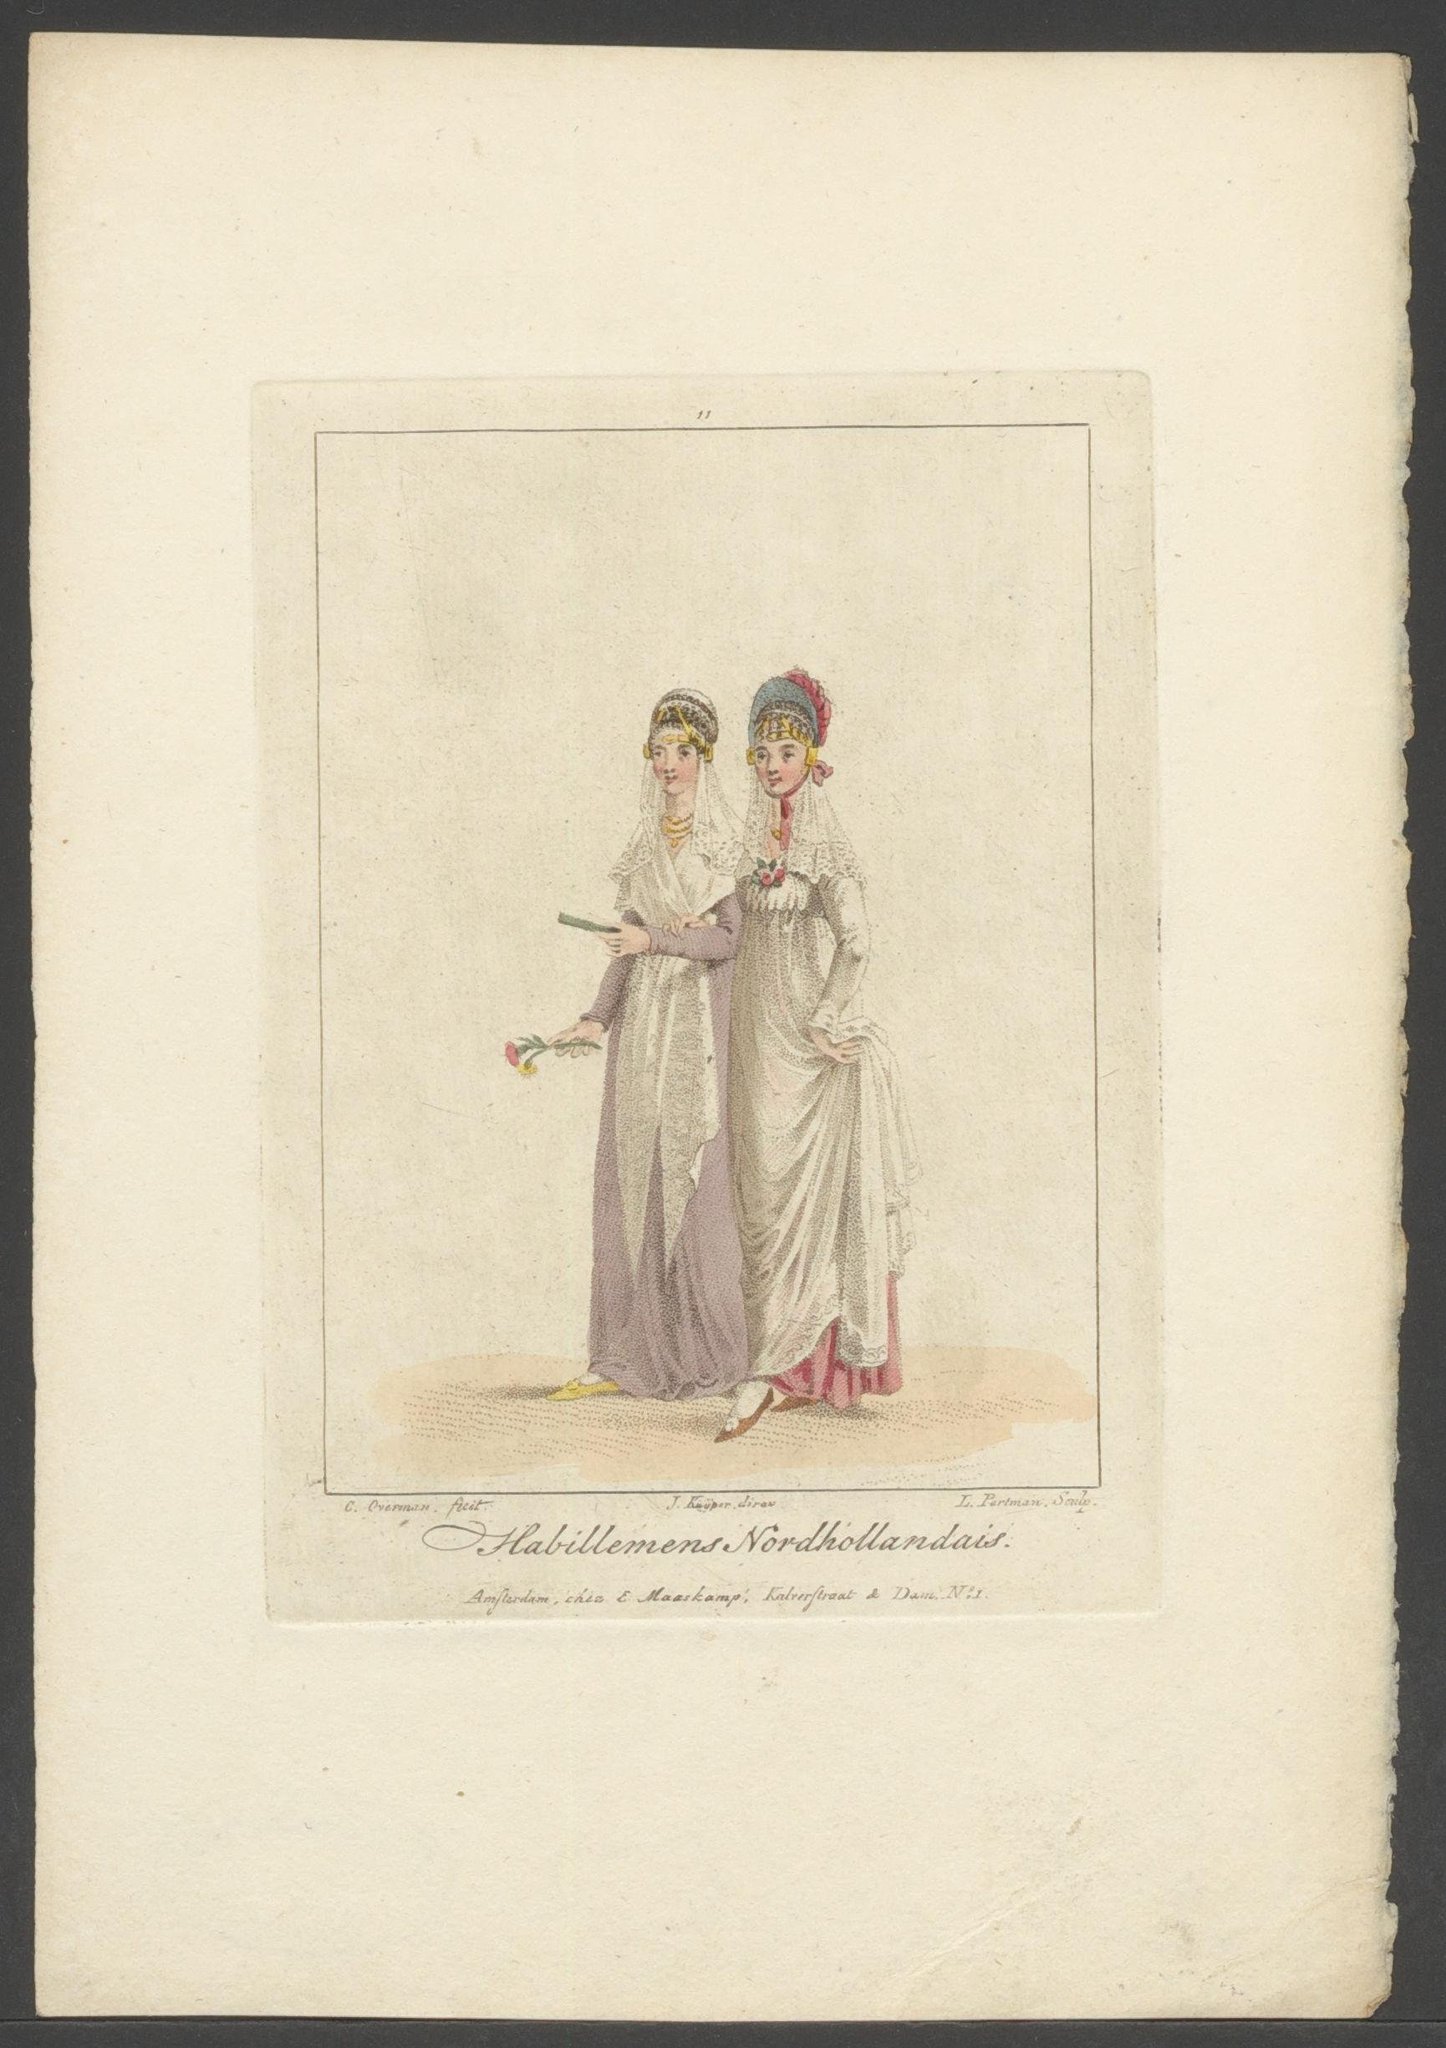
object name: costume print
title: Jonge dames van Noord-Holland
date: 1813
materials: paper, watercolor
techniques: etching, hand coloring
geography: netherlands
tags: clothes, costume (+ women's clothes), folk costume, regional costume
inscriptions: collector's mark, collector's mark: Lugt 1641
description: Twee jonge dames van Noord-Holland, op een wandeling. Bij de prent zit ook een blad met de Franse titel. Onderdeel van de verkleinde kopieën uit 1812 naar de platen van Nederlandse klederdrachten uit de jaren 1803-1807. Onderwerpsrubrieken binnen de Atlas Zeden en Gewoonten: De Kleeding, Volkskleederdracht.